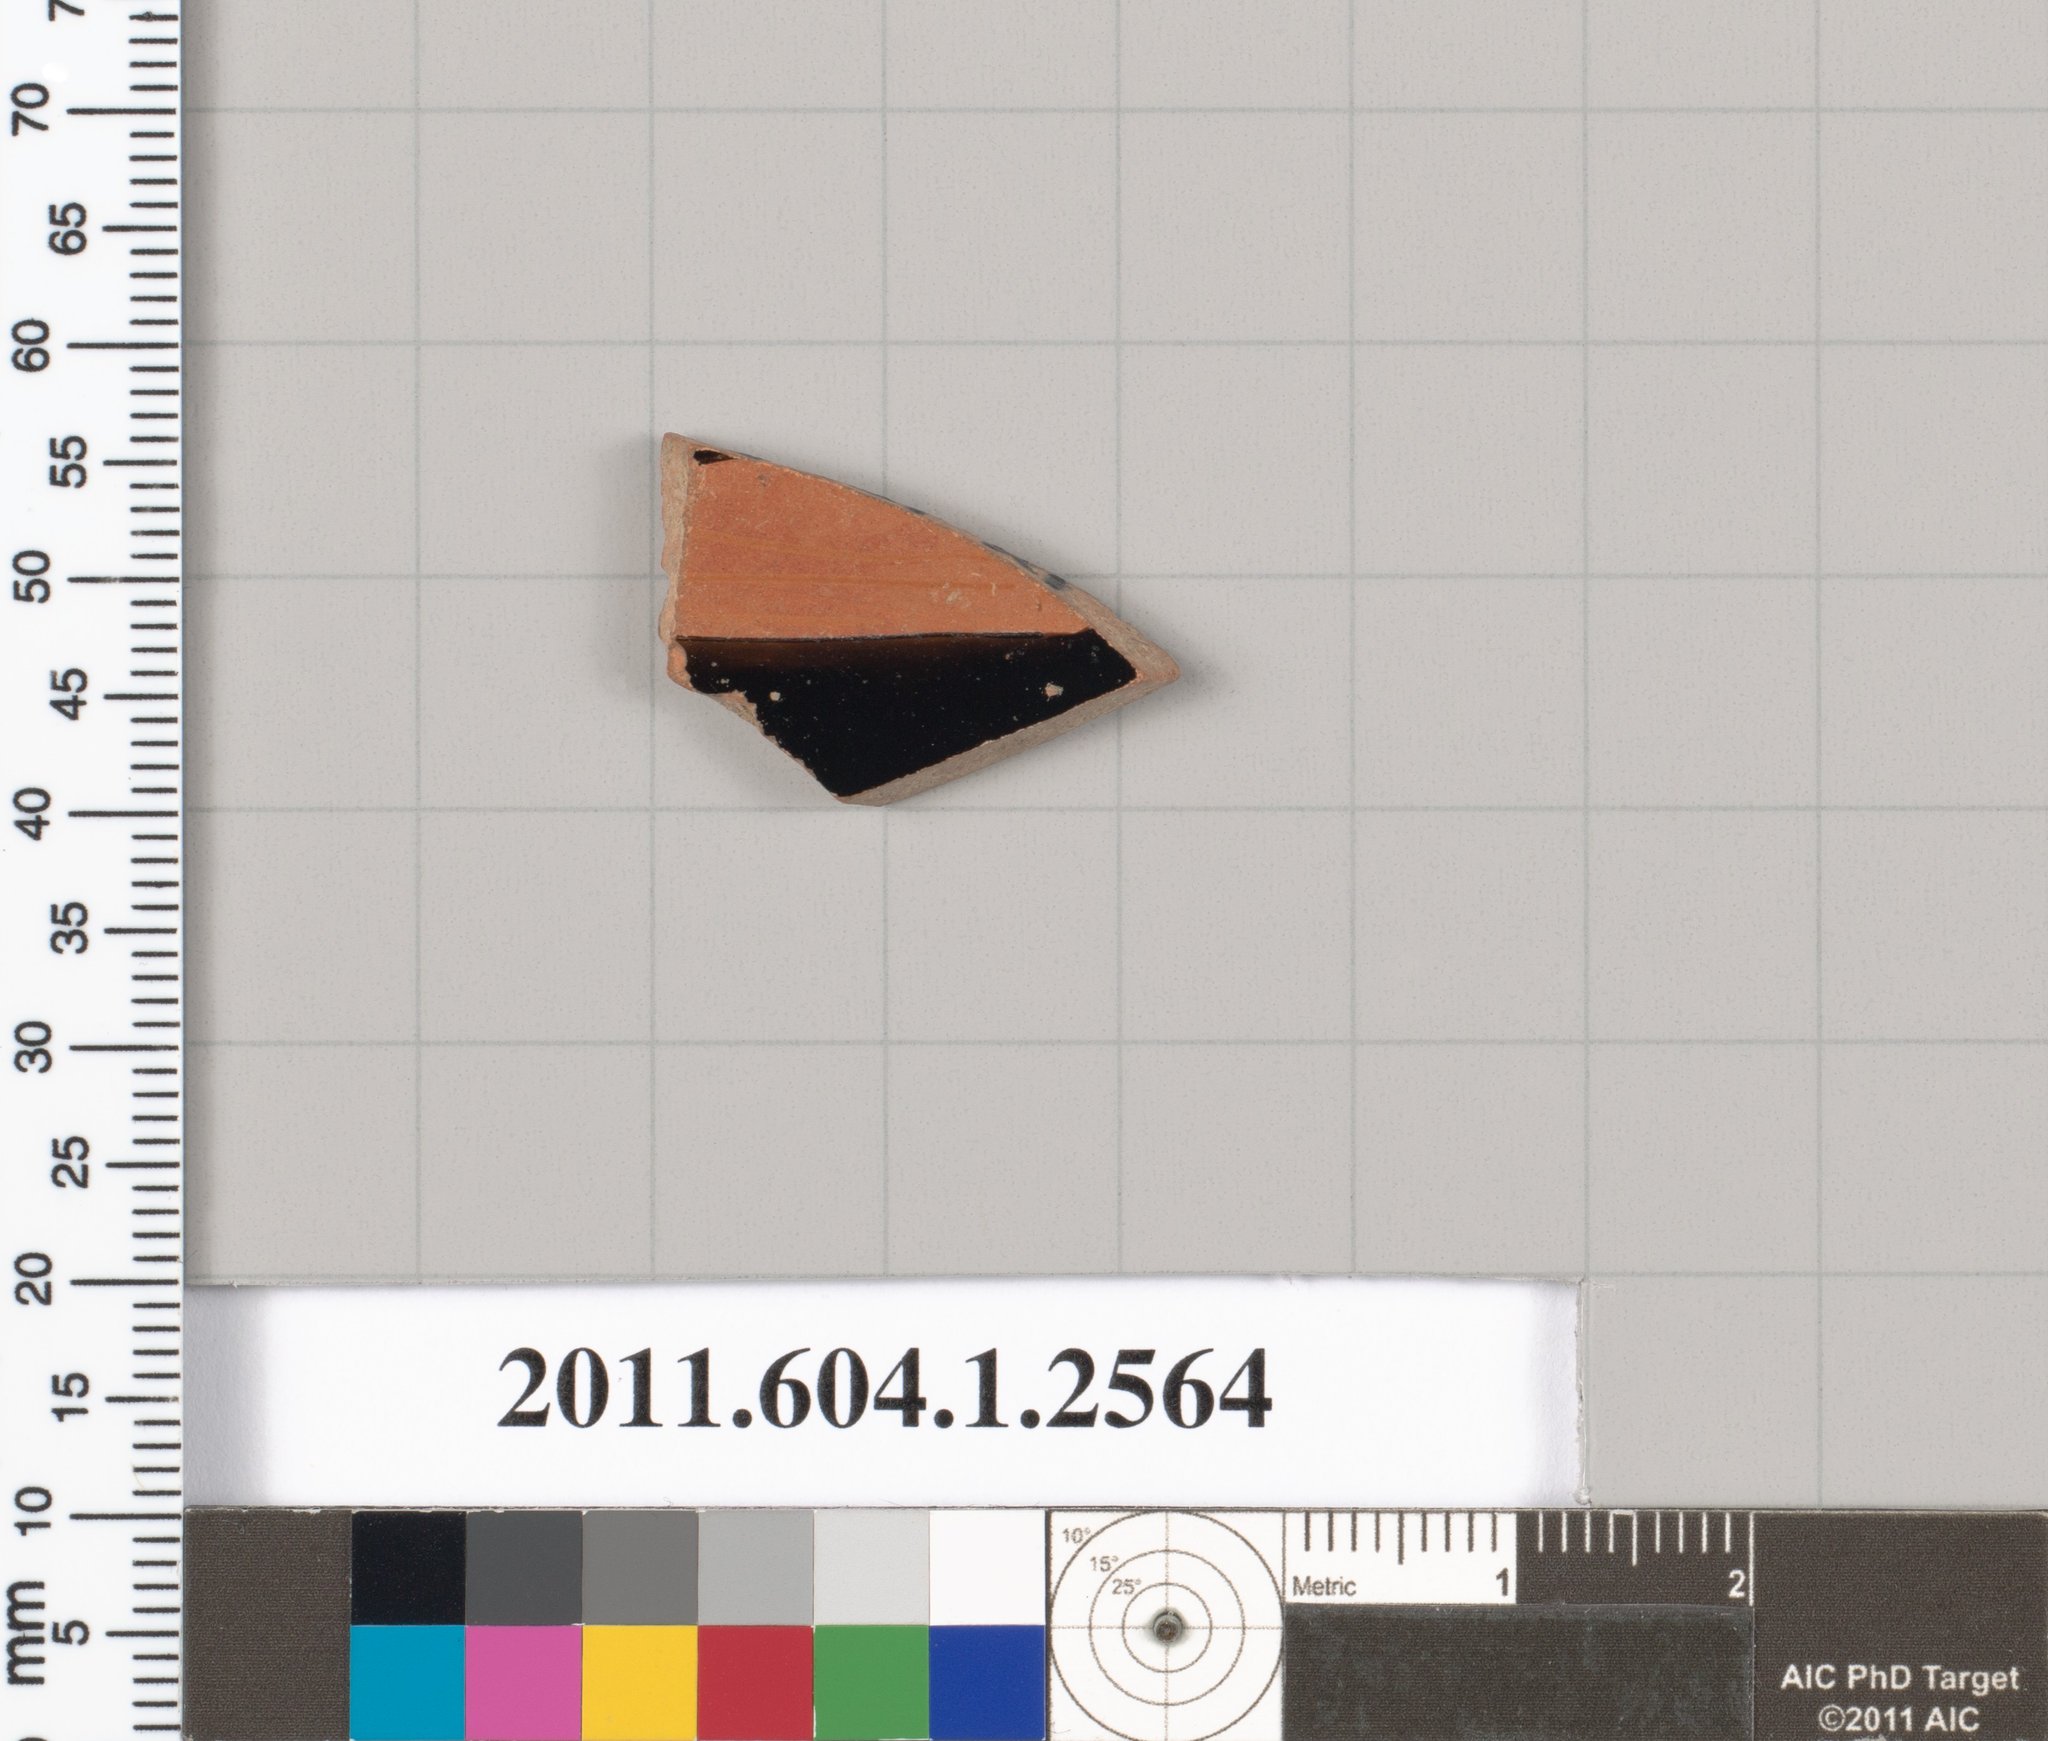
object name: kylix fragment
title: Terracotta fragment of a kylix (drinking cup)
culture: greek, attic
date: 475-451 BCE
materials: terracotta